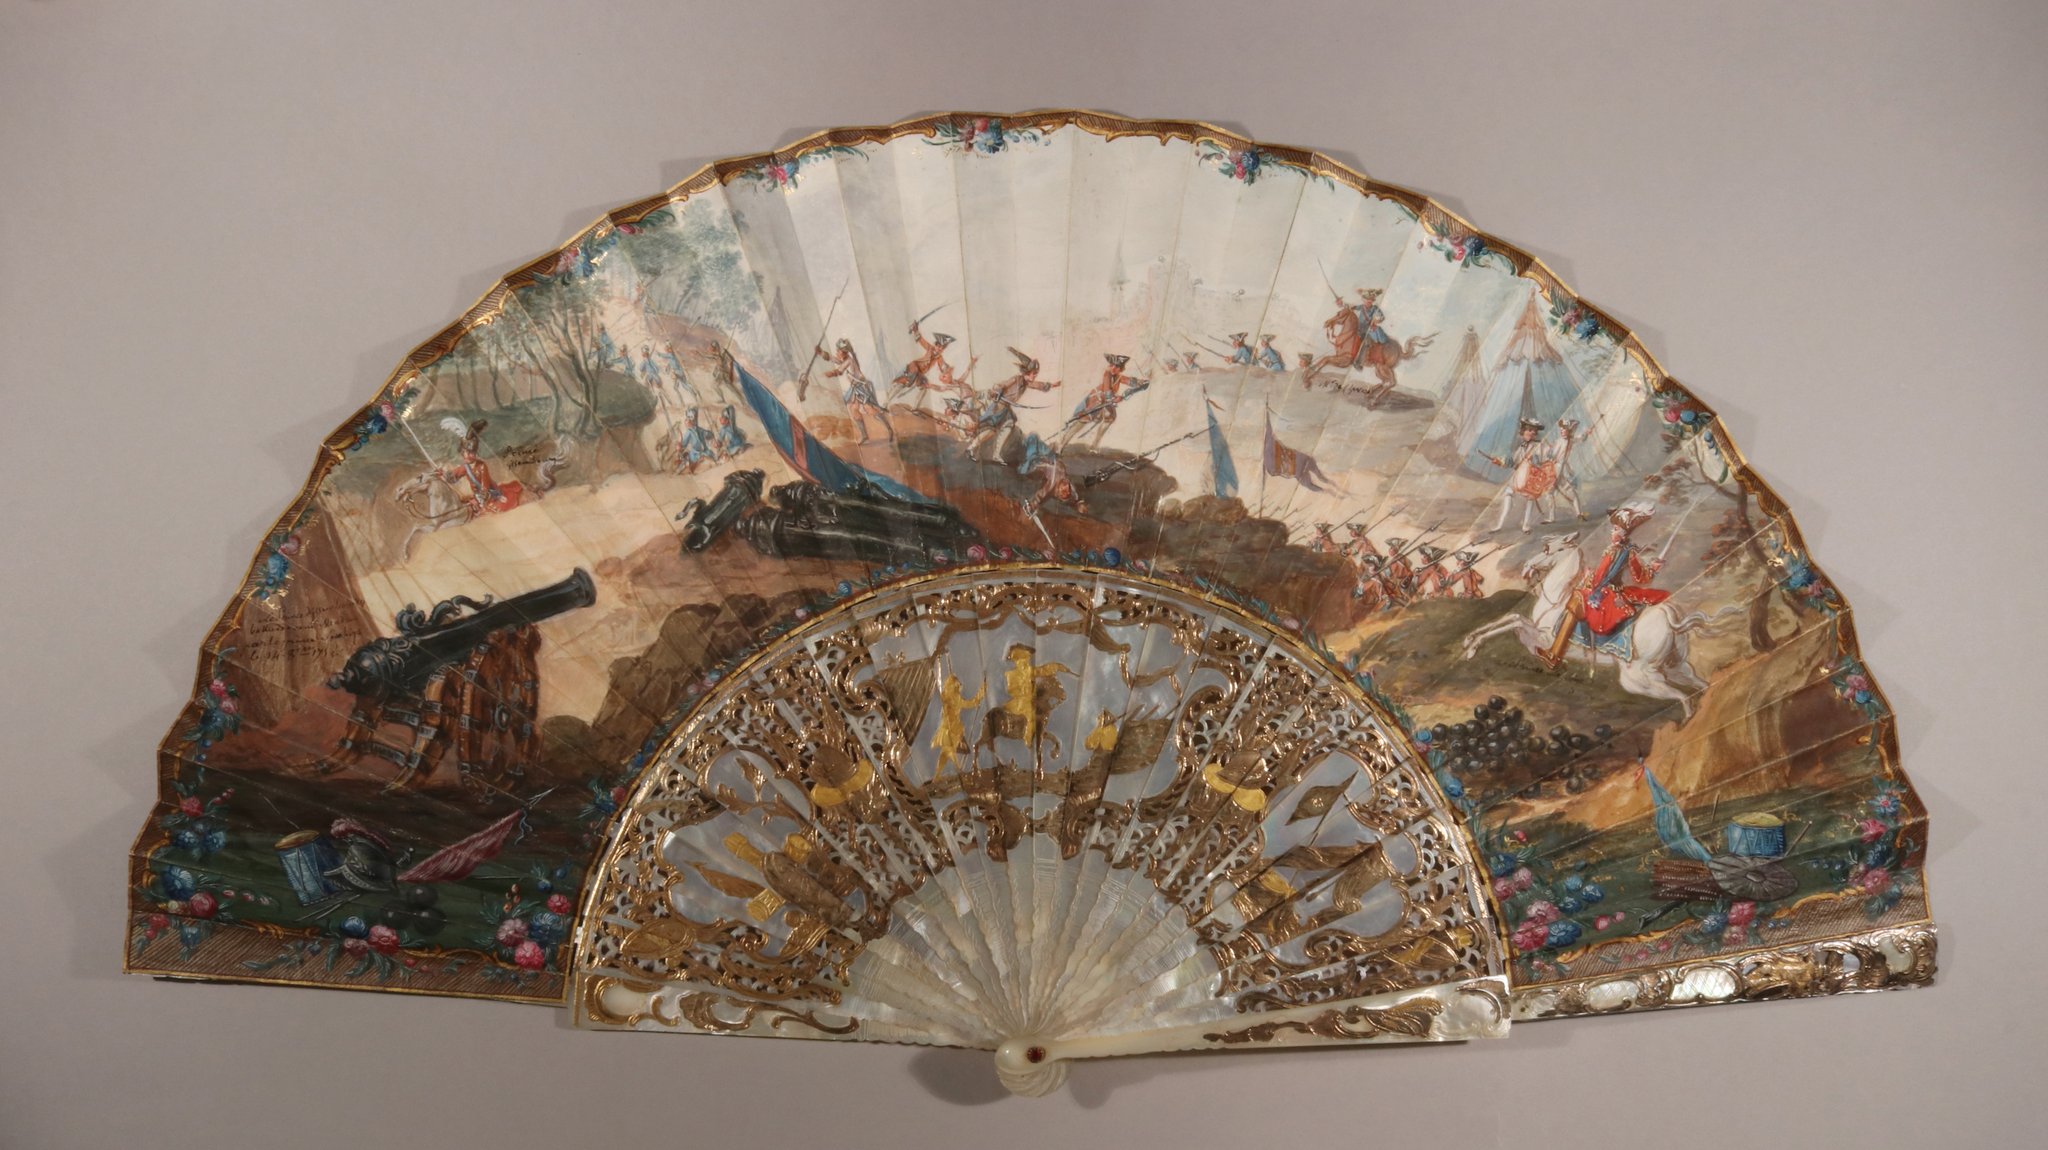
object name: fan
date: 1758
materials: gouache, mother of pearl, parchment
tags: battles,soldiers,cannons,horses